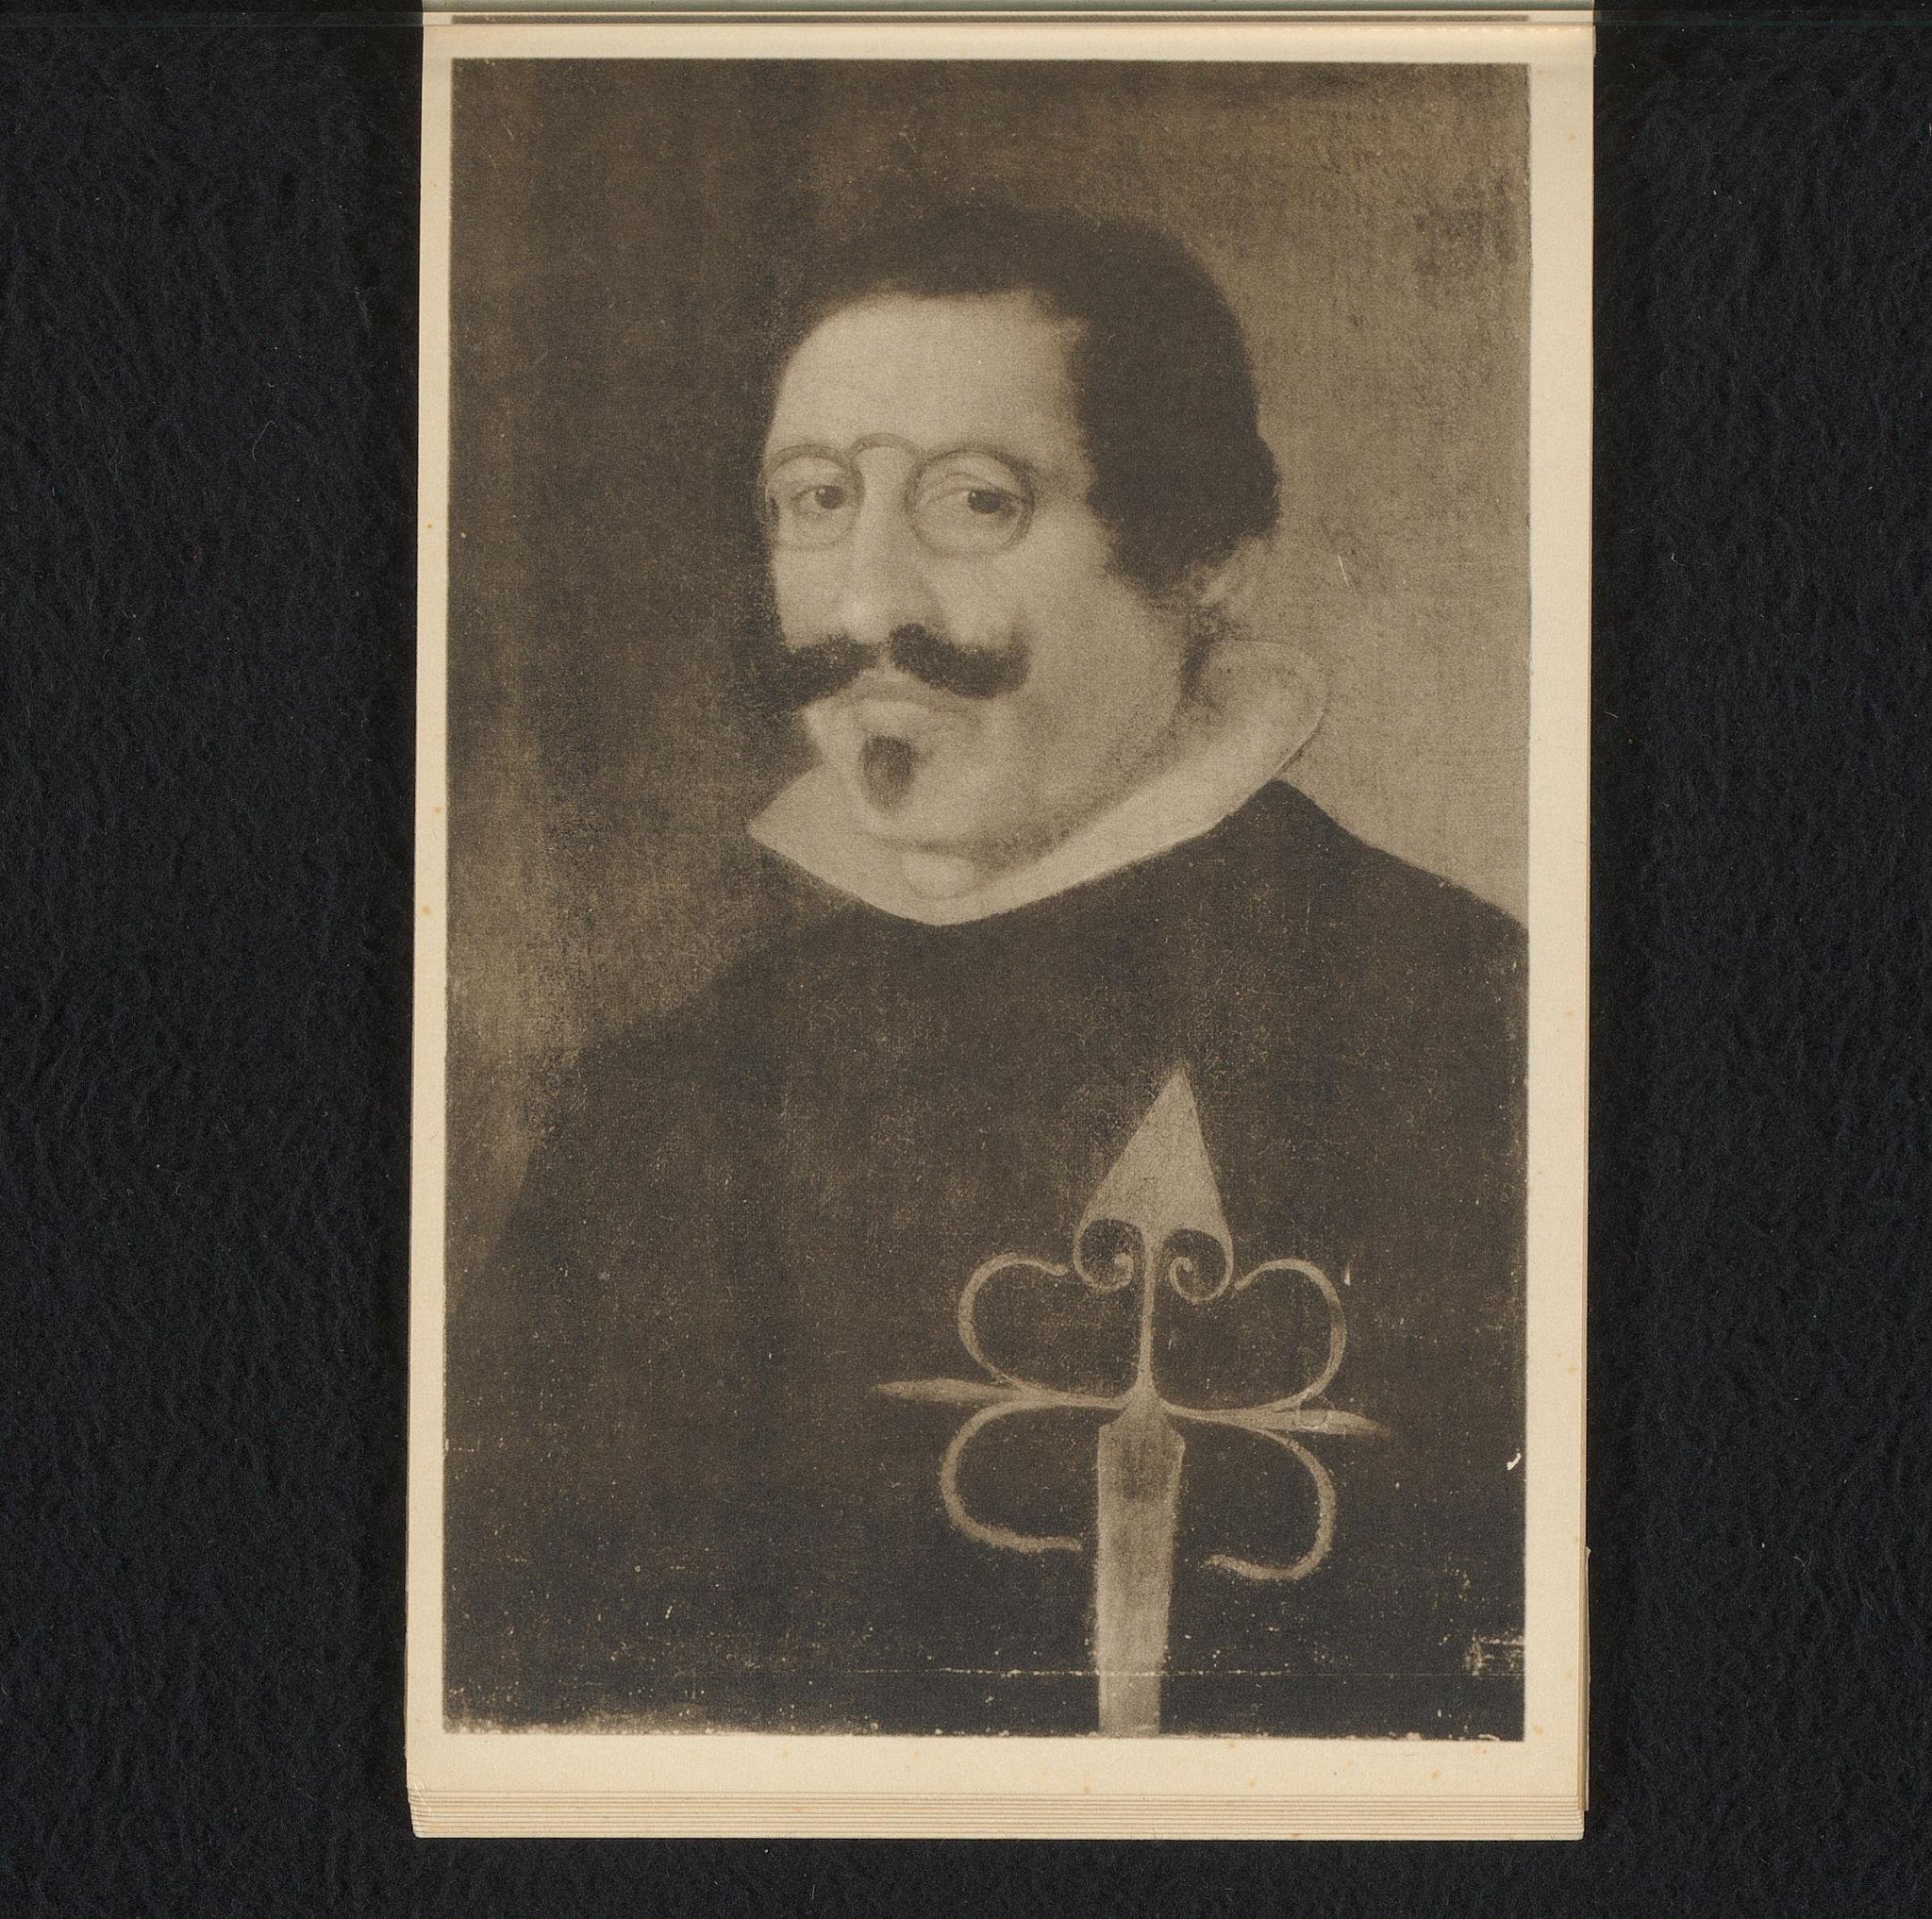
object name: reproduction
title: Museo Cerralbo. Madrid. Retrato de D. Antonio Sancho Davila y Toledo, tercer Marqués de Velada, de San Roman' Gobernador de Milan, etc. con la cruz de la Orden de Santiago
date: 1924-1930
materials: cardboard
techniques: photograph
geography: madrid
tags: permanent exhibition, museum, picture, painting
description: Prentbriefkaart maakt deel uit van een album.